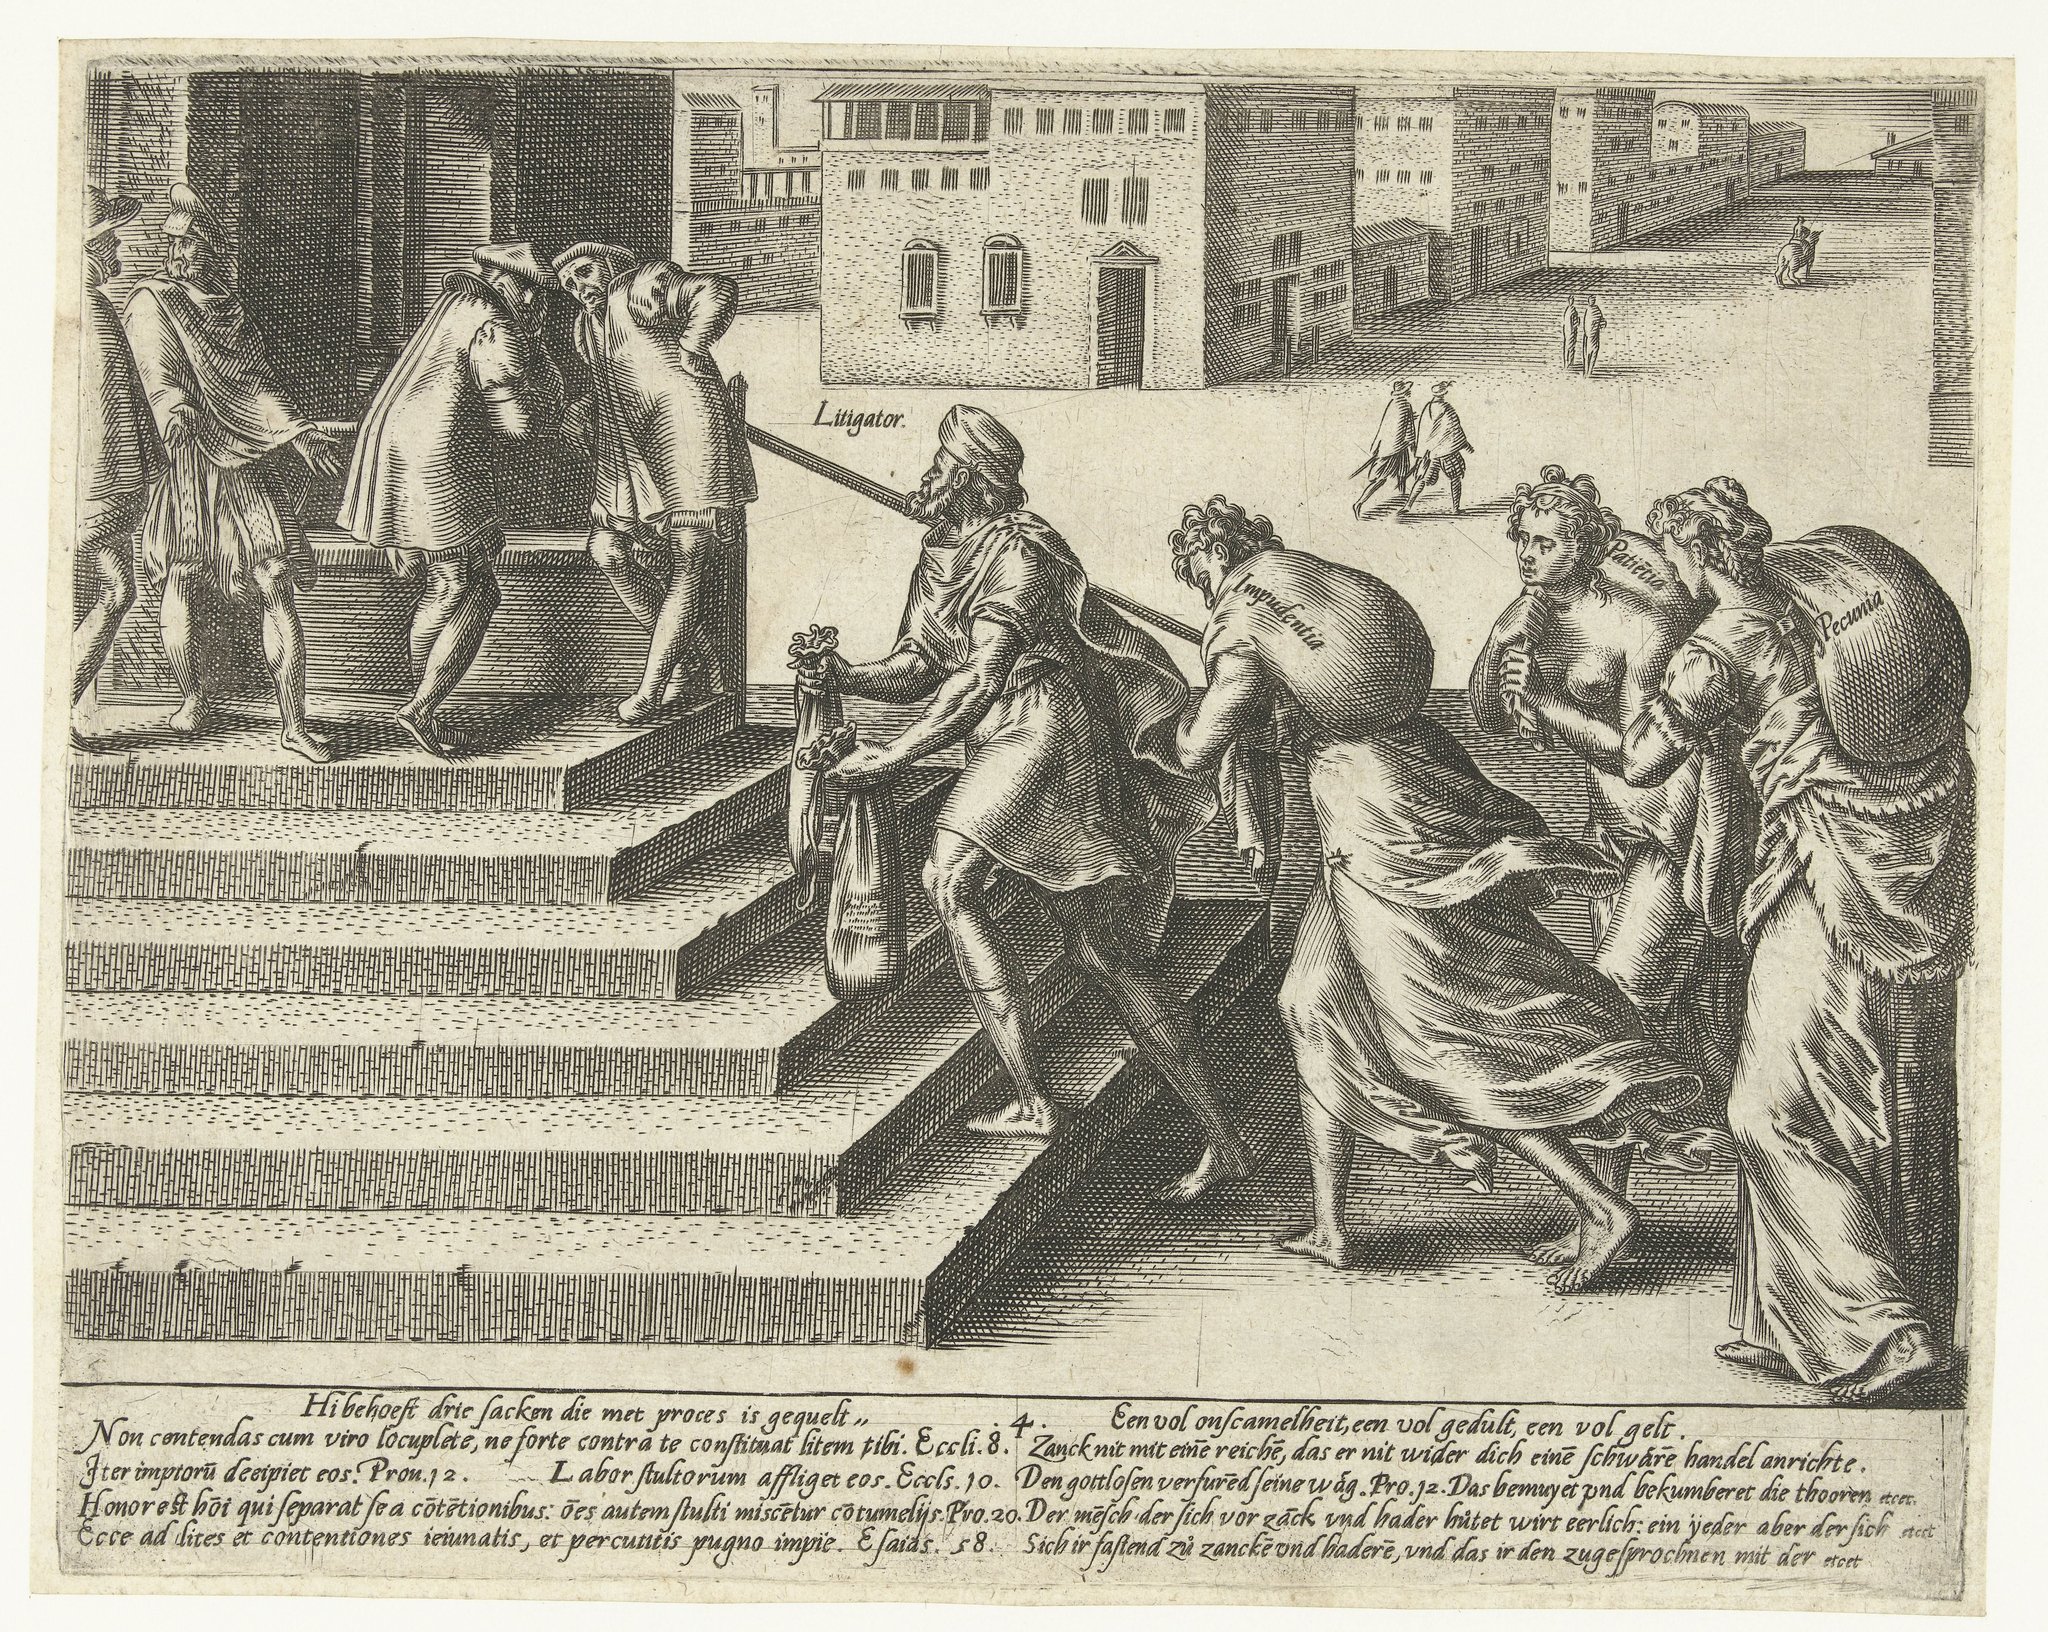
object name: print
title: Wie procedeert, moet schaamteloos, geduldig en rijk zijn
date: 1597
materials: paper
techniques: engraving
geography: haarlem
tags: patience; 'patienza' (ripa), litigation, legal proceedings, lawsuit, 'pecunia' (ripa), indecency, impudence; 'sfacciatigine' (ripa)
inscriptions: collector's mark: Lugt 2228a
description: Een procederende man (Litigator) loopt een trap op met twee zaken in de handen en achter zich drie vrouwen die zakken dragen met in het Latijn de opschriften 'Schaamteloosheid', 'Geduld' en 'Geld'. Uitvoerig onderschrift in Nederlands, Duits en Latijn. Deze prent is onderdeel van een serie van acht prenten over hebzucht, bedrog en procederen.